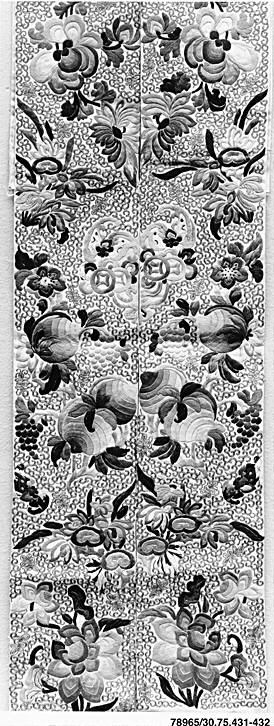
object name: sleeve band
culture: chinese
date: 1801-1900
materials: metal thread, silk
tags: flowers